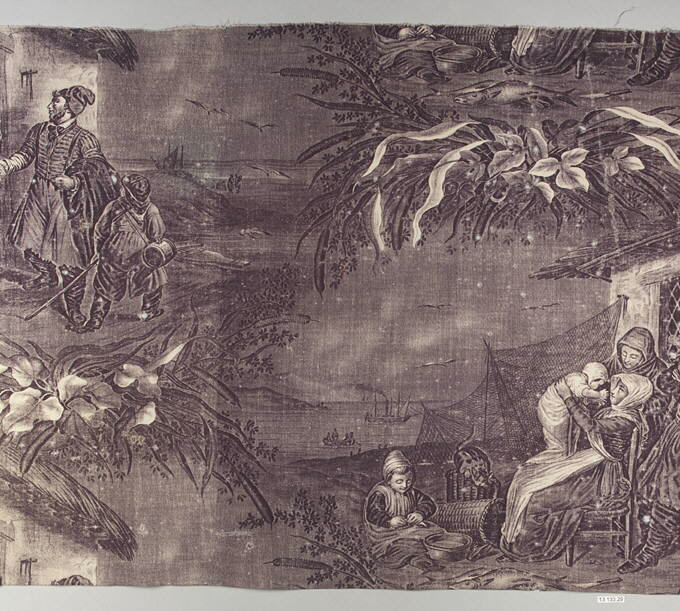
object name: furnishing textile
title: Pictorial print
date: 1830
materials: cotton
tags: infants,men,women